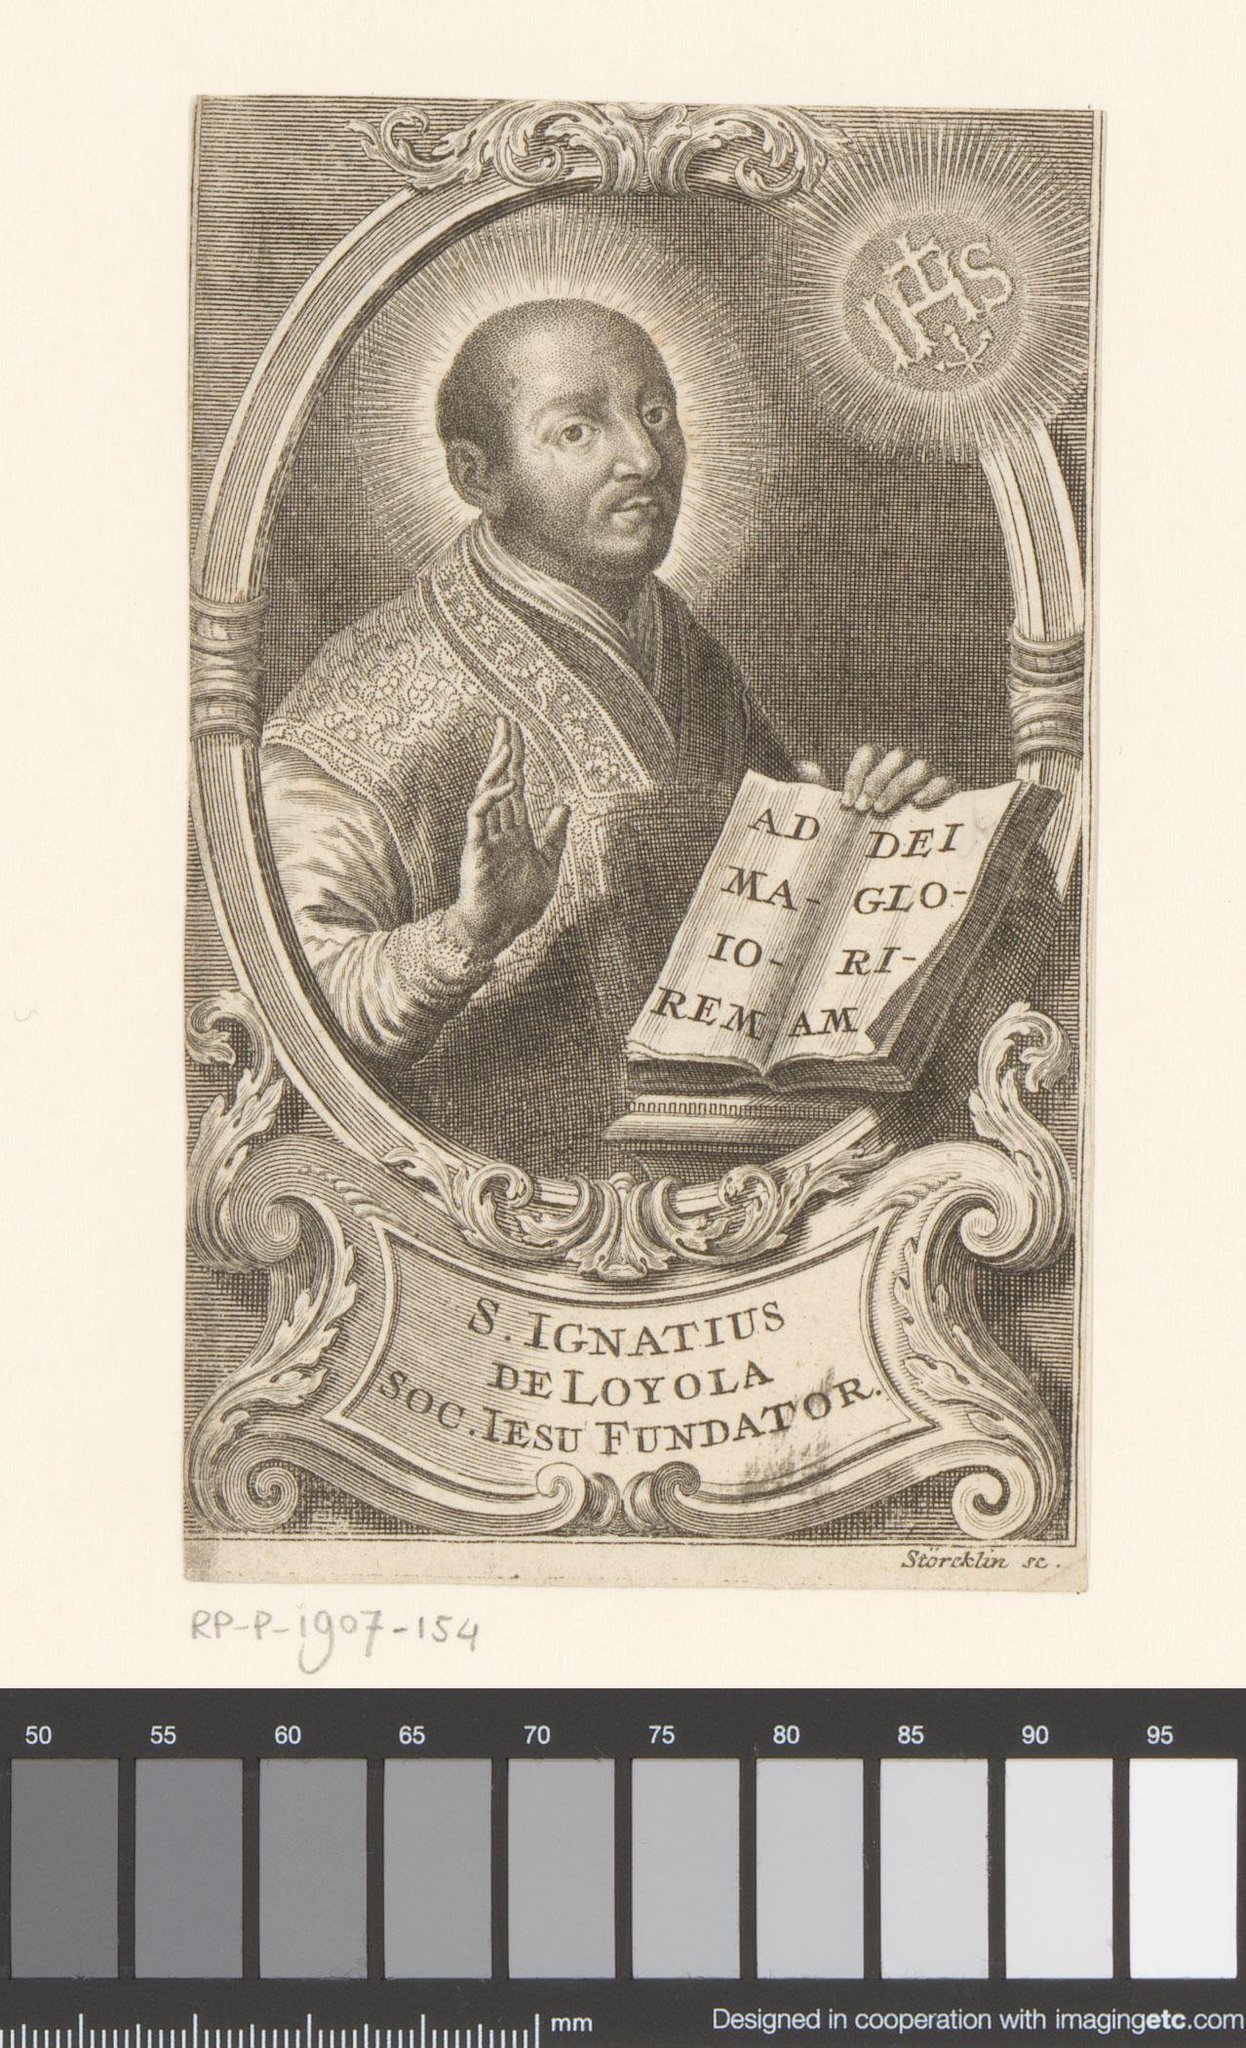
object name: print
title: Heilige Ignatius van Loyola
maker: johann heinrich störchlin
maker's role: print maker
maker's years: 1687-1737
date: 1697-1737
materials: paper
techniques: engraving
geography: germany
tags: rome, clergyman, ihs ('iesus hominum salvator') ~ symbol of christ, historical persons, book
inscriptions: collector's mark: Lugt 2228